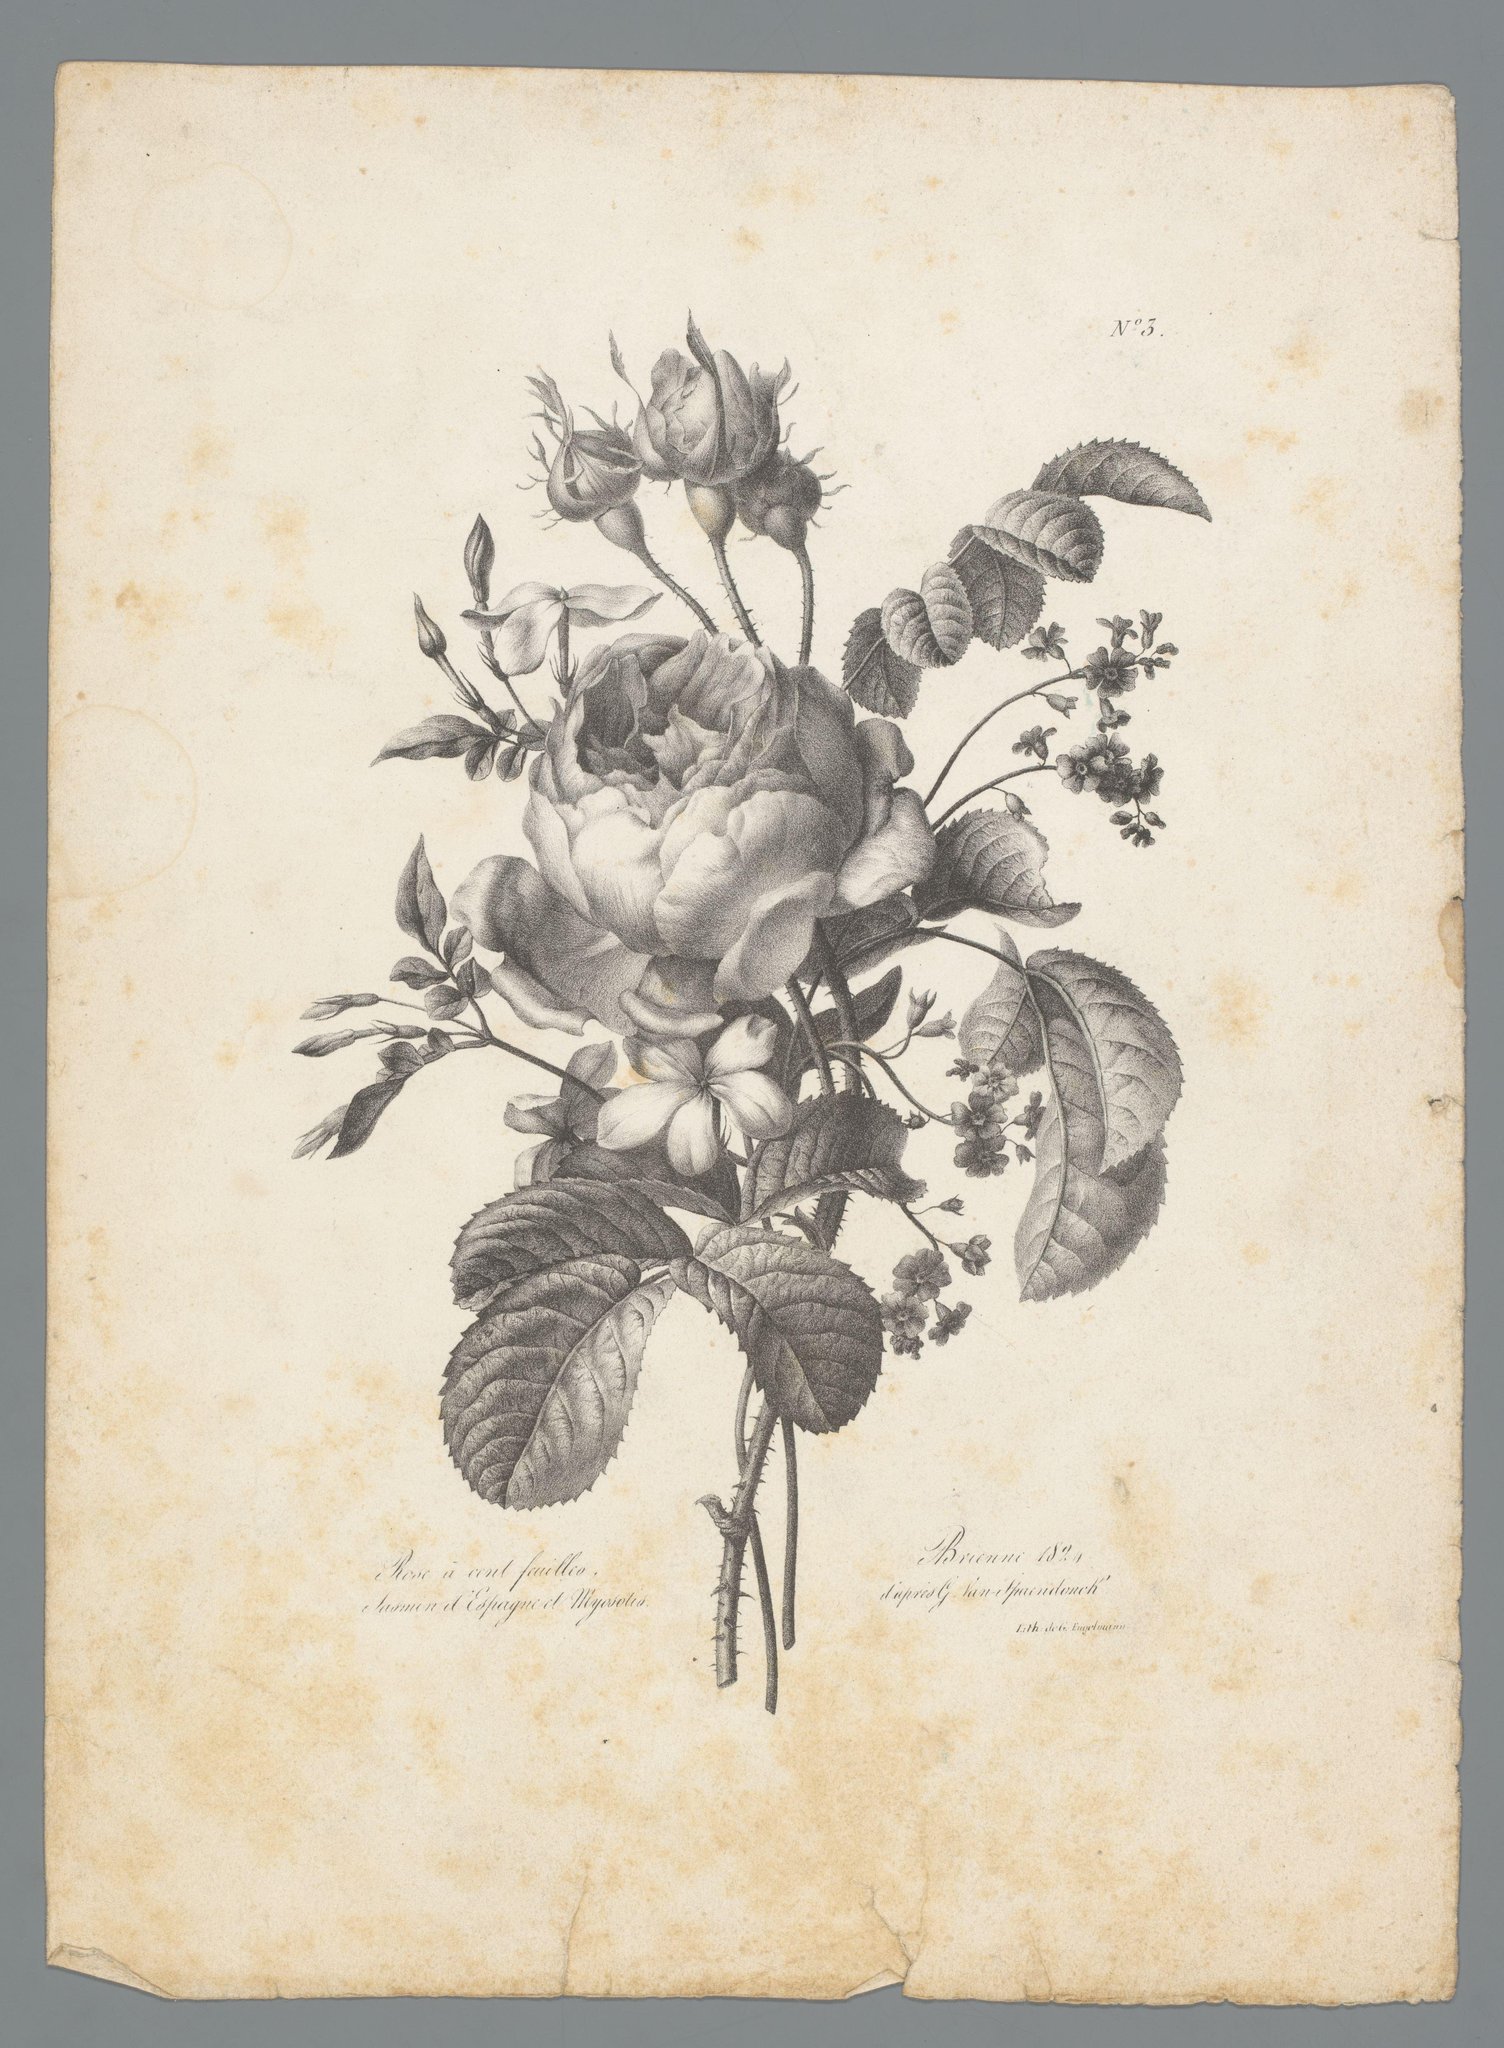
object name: print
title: Boeket met koolroos, Spaanse jasmijn en magnolia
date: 1824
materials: paper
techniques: lithograph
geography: paris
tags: cut flowers; nosegay, bunch of flowers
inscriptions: collector's mark: Lugt 2233